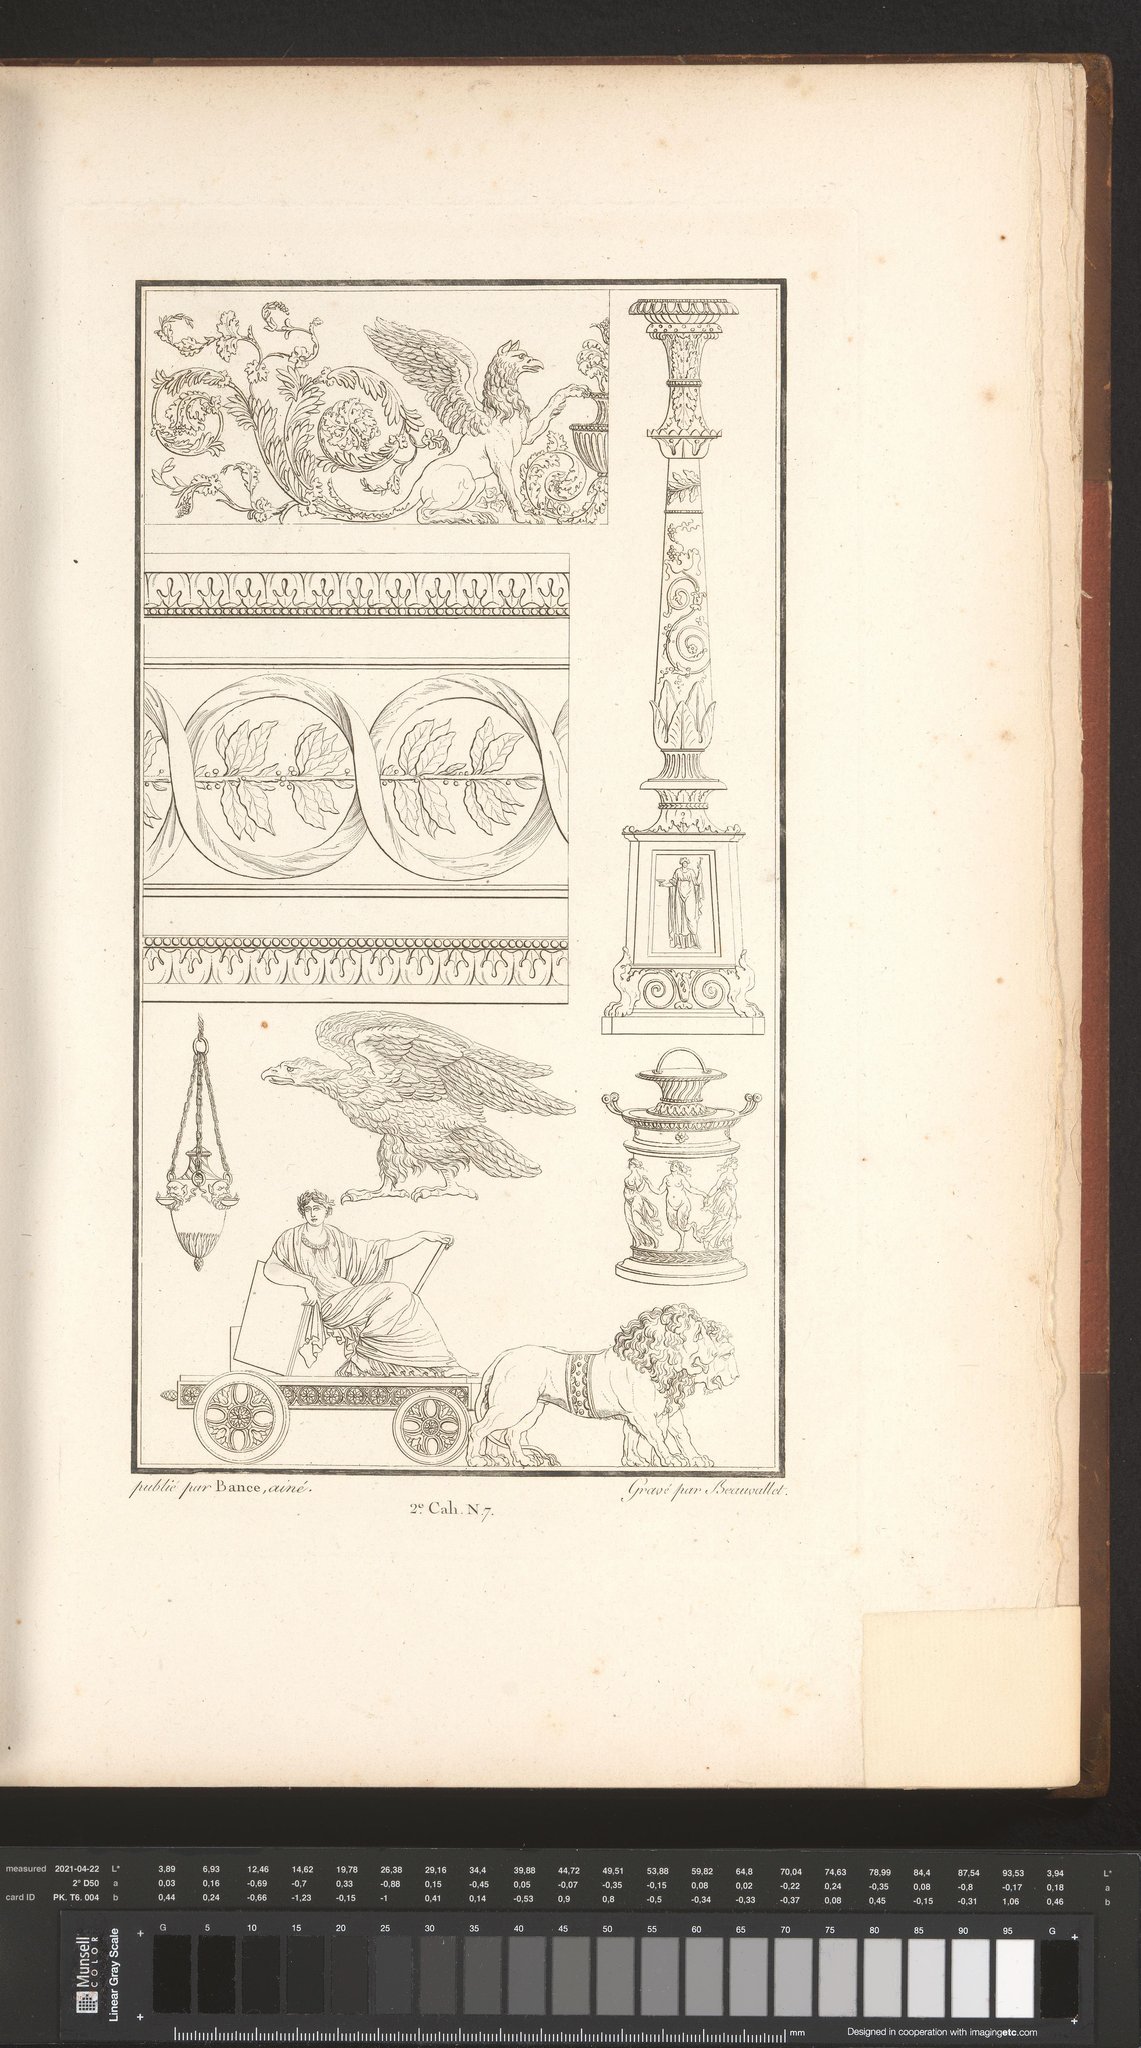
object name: ornament print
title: Friezen, kandelaar en vrouw op leeuwenkar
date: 1820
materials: paper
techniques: etching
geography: paris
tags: ornaments ~ art, candlestick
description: Ornamentprent met o.a. verschillende friezen, een kandelaar en een vrouw rijdend op een wagen getrokken door leeuwen. Onderdeel (2e. Cah. N. 7) van het prentalbum met twee series van in totaal 138 ornamentprenten door Beauvallet en Normand, 'Fragmens d'Ornemens dans le Style Antique'.